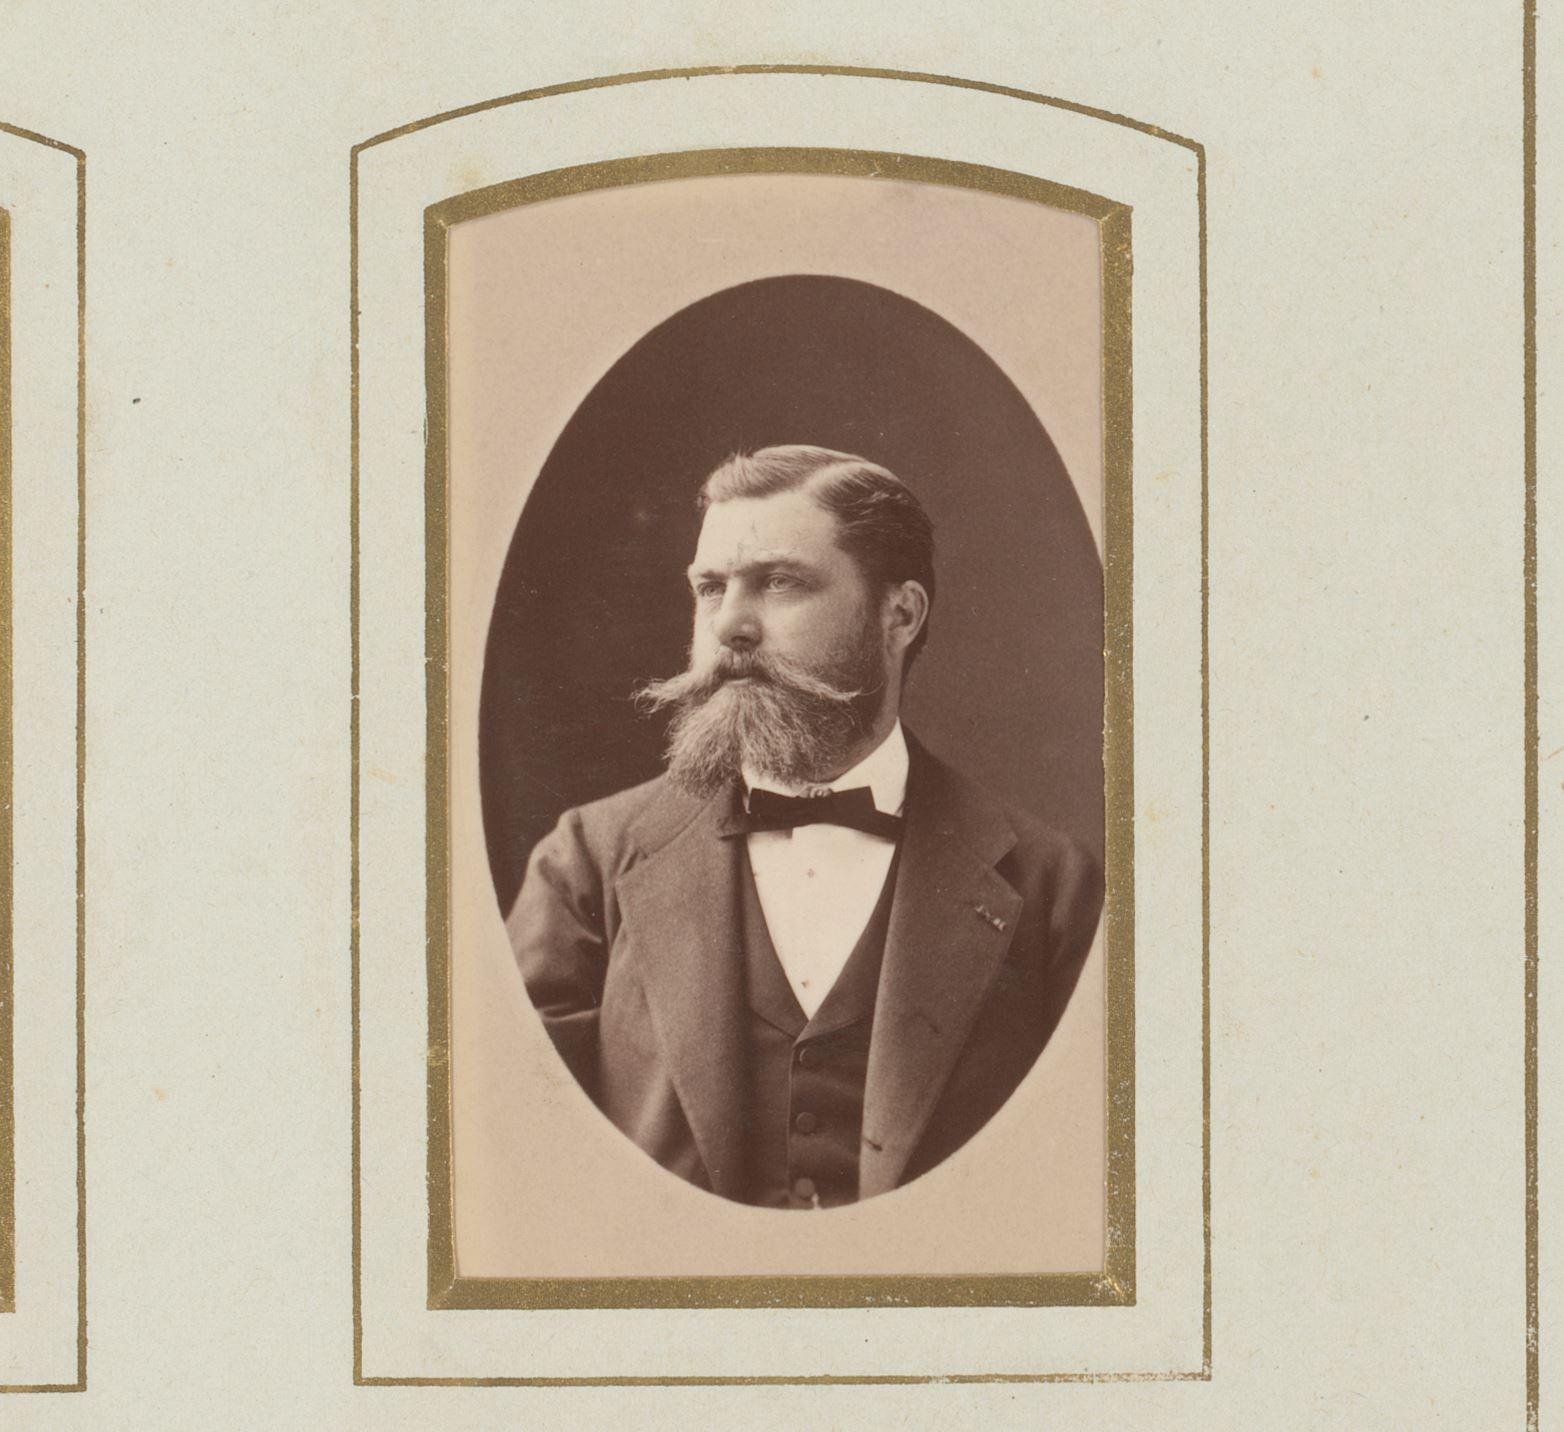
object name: semi enamel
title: Portret van een man met snor en baard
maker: alphonse-justin liébert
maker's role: fotograaf, marinier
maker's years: 1827-1914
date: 1880-1900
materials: cardboard, celluloid, photographic support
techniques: albumen print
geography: paris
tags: moustache, historical persons, beard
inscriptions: inscription: ‘A. Liébert/ Paris/ 6, RUE de LONDRES, 6/ CHAUSSÉE D'ANTIN/ Hôtel Privé/ Tous les clichés sont conservés/ Année 1878’